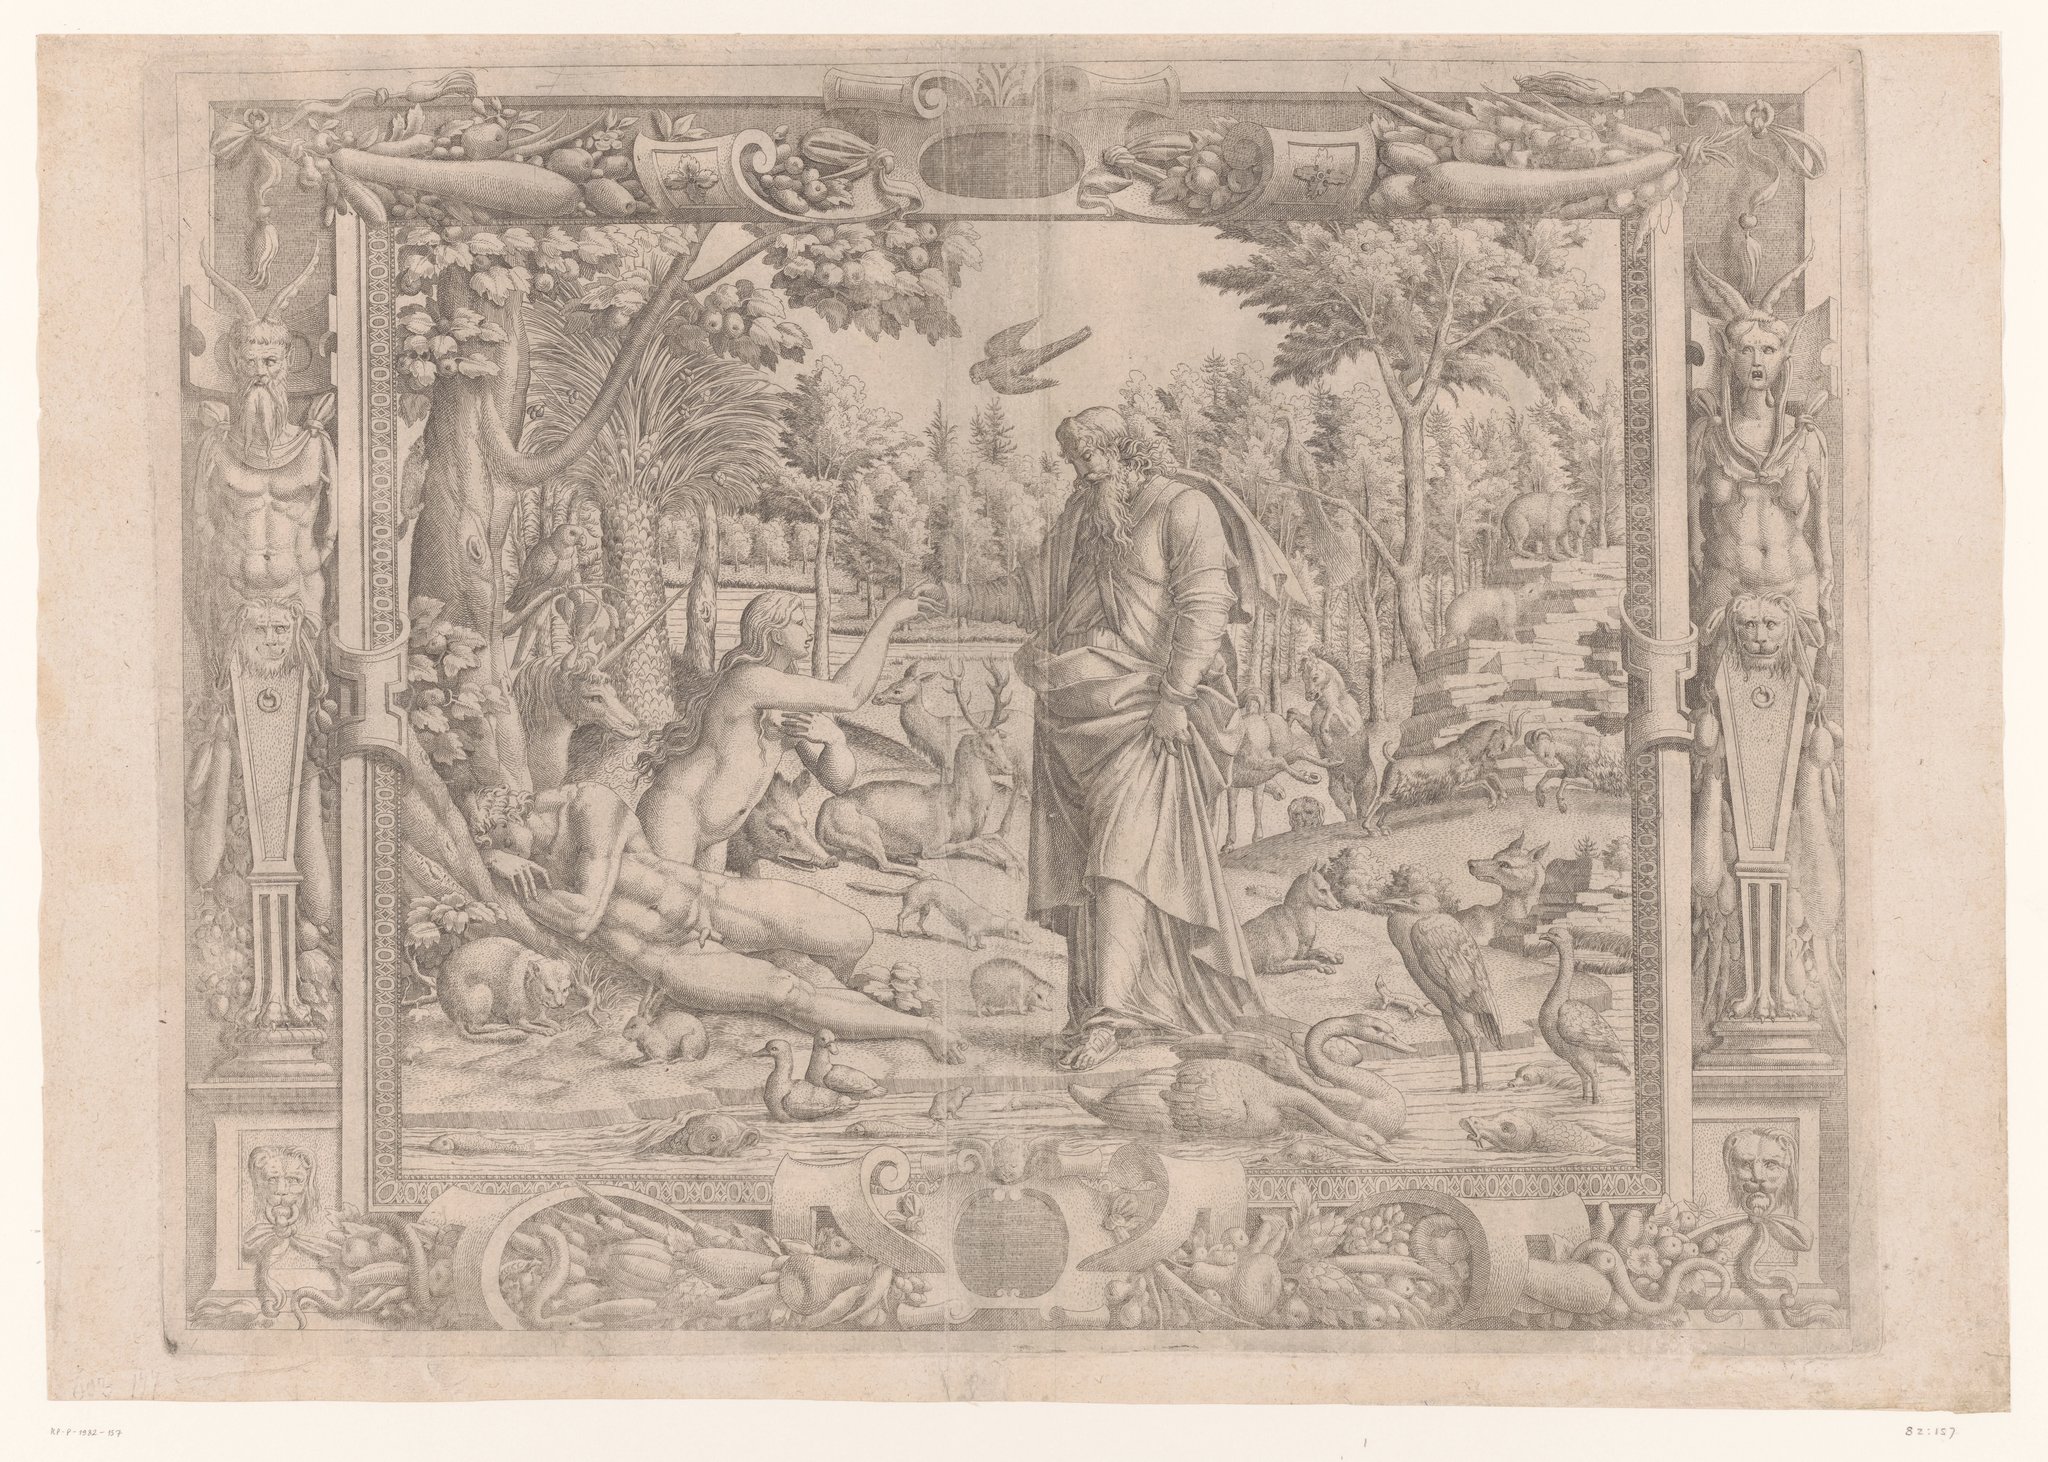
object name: print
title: Schepping van Eva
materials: paper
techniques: etching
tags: creation of eve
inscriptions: collector's mark: Lugt 2760, collector's mark: Lugt 2228